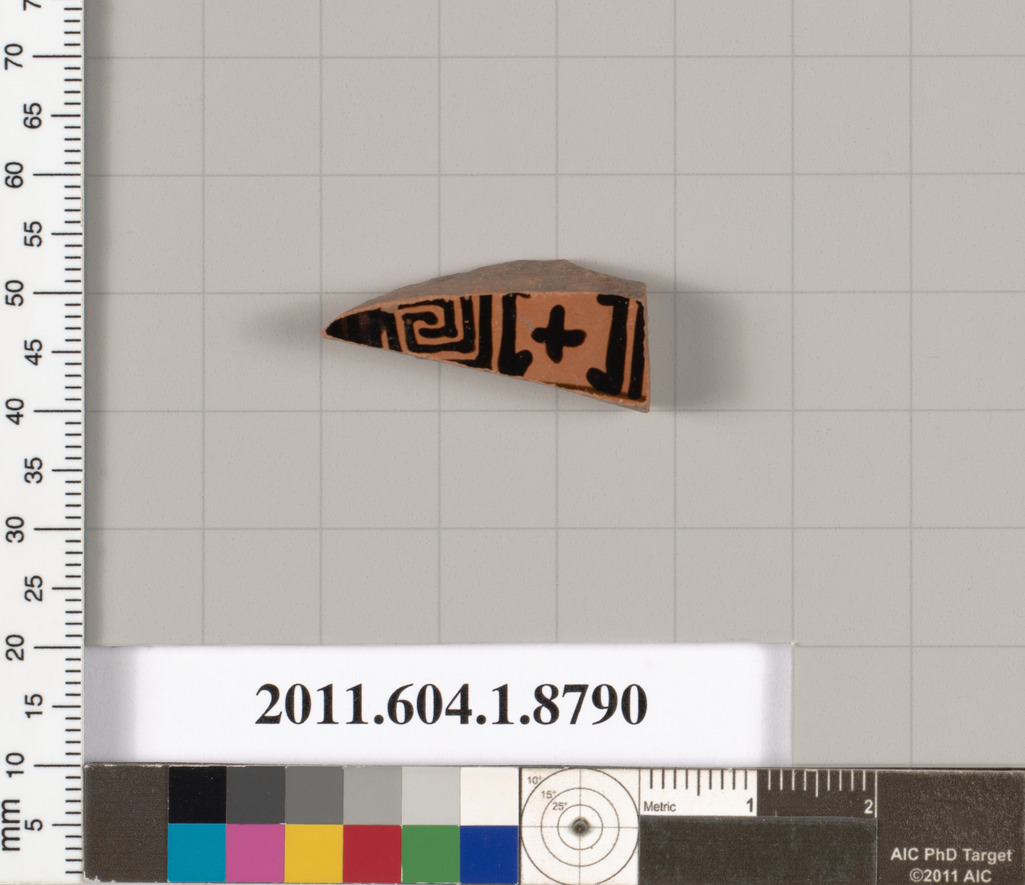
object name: kylix fragment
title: Terracotta fragment of a kylix (drinking cup)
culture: greek, attic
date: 490-480 BCE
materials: terracotta